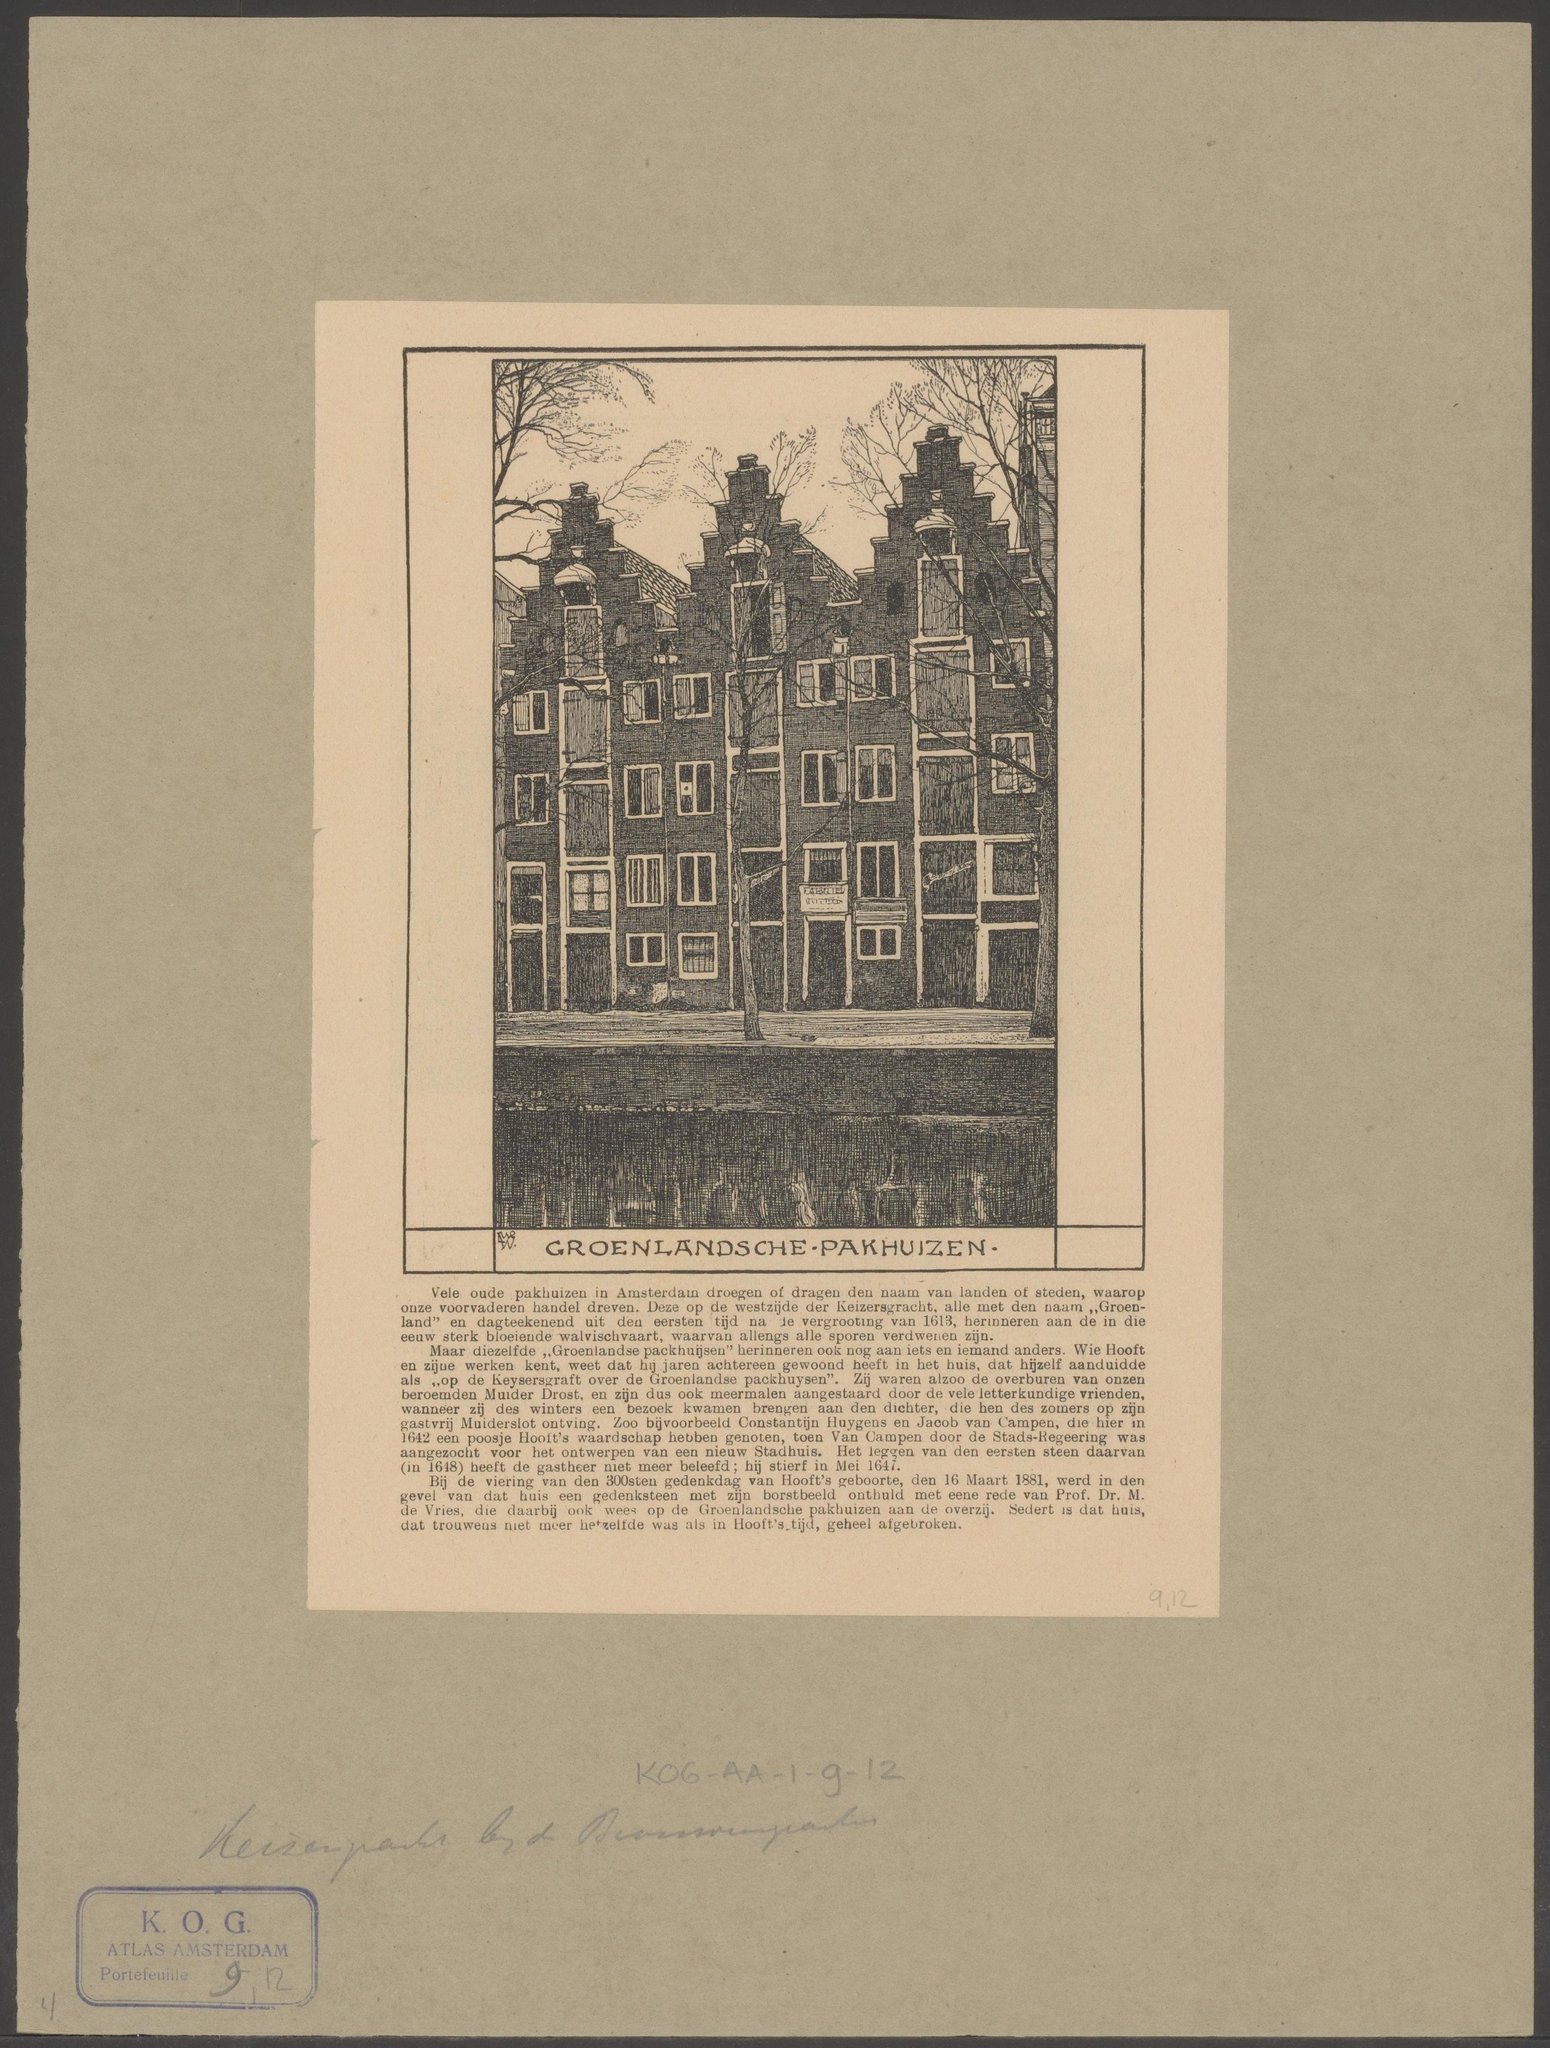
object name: photomechanical print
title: Gezicht op de Groenlandse Pakhuizen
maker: willem wenckebach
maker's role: designer, draughtsman, painter, print maker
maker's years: 1860-1937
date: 1870-1923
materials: paper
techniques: letterpress printing, line block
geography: amsterdam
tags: warehouse (~ harbour), city-view in general; 'veduta', canal, façade (of house or building), street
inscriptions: collector's mark: ‘9,12’ Lugt 1641b, inscription: ‘Keizerspak bij de Brouwersgracht’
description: Onderwerpsrubriek binnen de Atlas Amsterdam: Kadijksplein, Karthuizerkerkhof, Kattegat, Kattenburg, Kapelsteeg O.Z., Enge Kerksteeg, Kerkstraat, Kinkerstraat, Kolk O.Z., Koningsplein, Kromboomsloot [Krom Boomssloot], Kostverlorenkade, Kwakersdwarspad, Kalverstraat, Keizersgracht (v.d. Brouwersgracht – Amstel), Klerensloot (Gedempte), Klimopstraat, Kloveniersburgwal, Kraansluis.